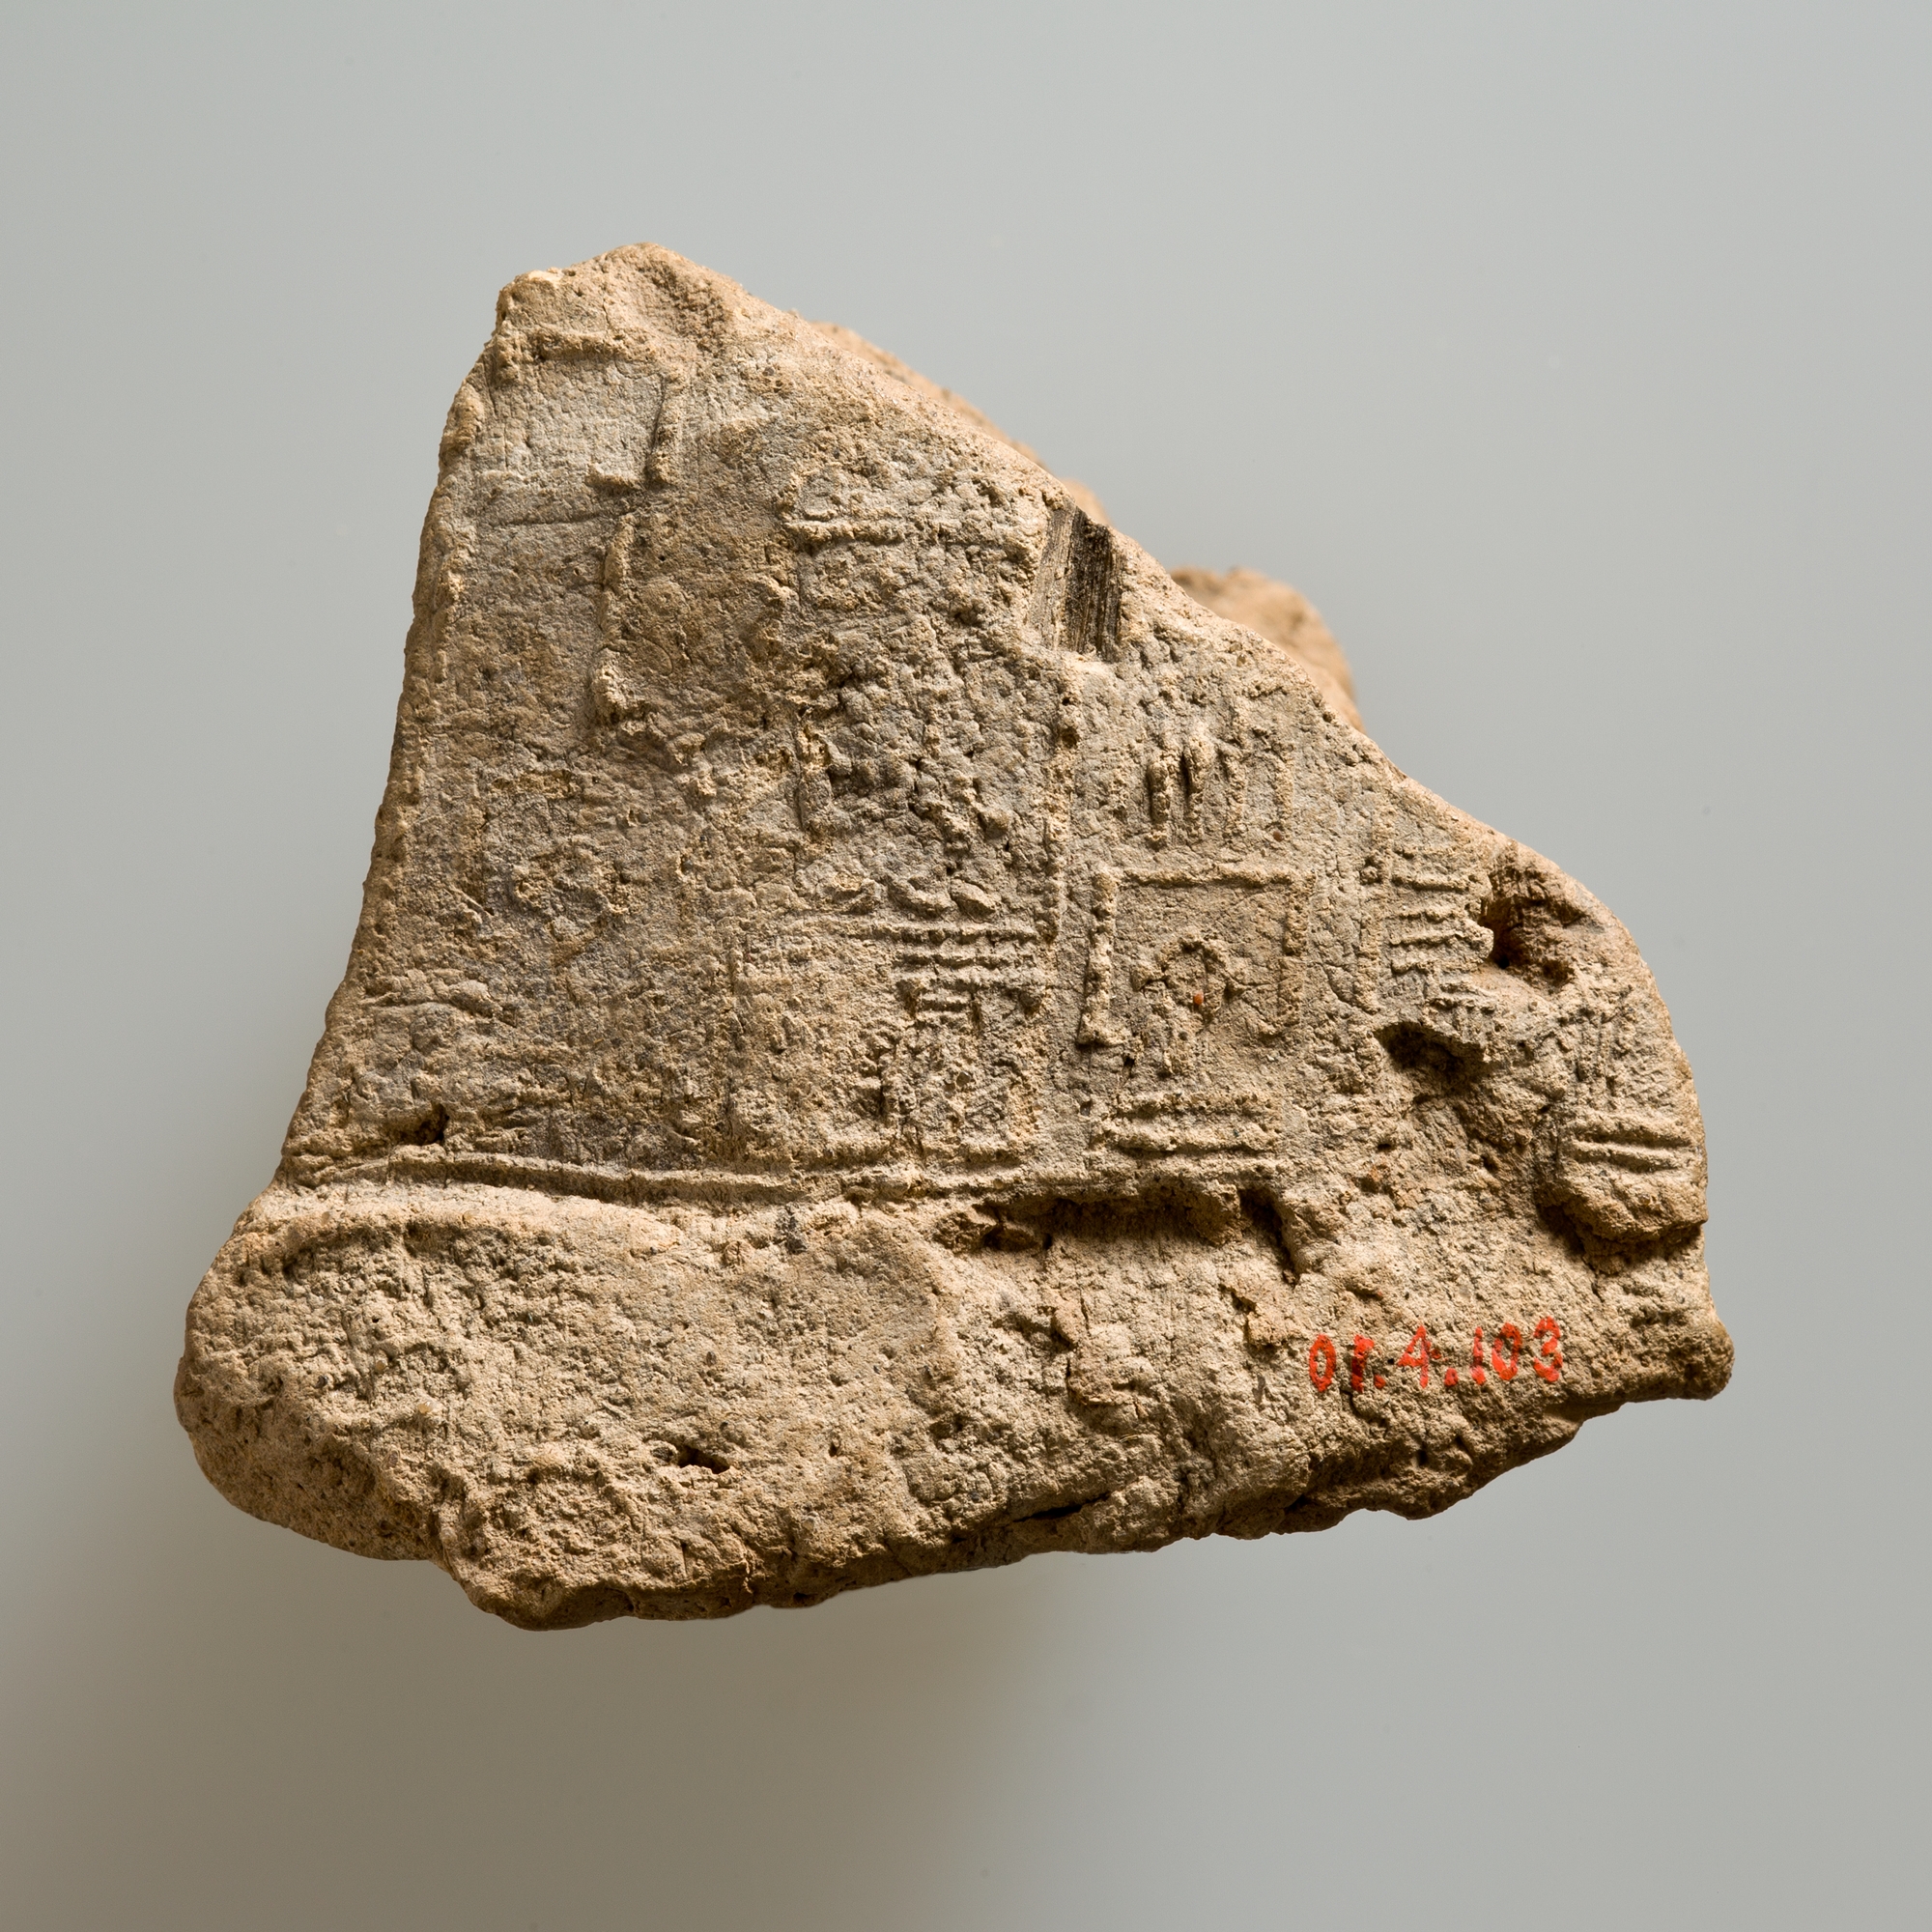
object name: sealing, jar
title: Clay jar sealing impressed faintly with name of Khasekhemwy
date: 2650 BCE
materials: clay